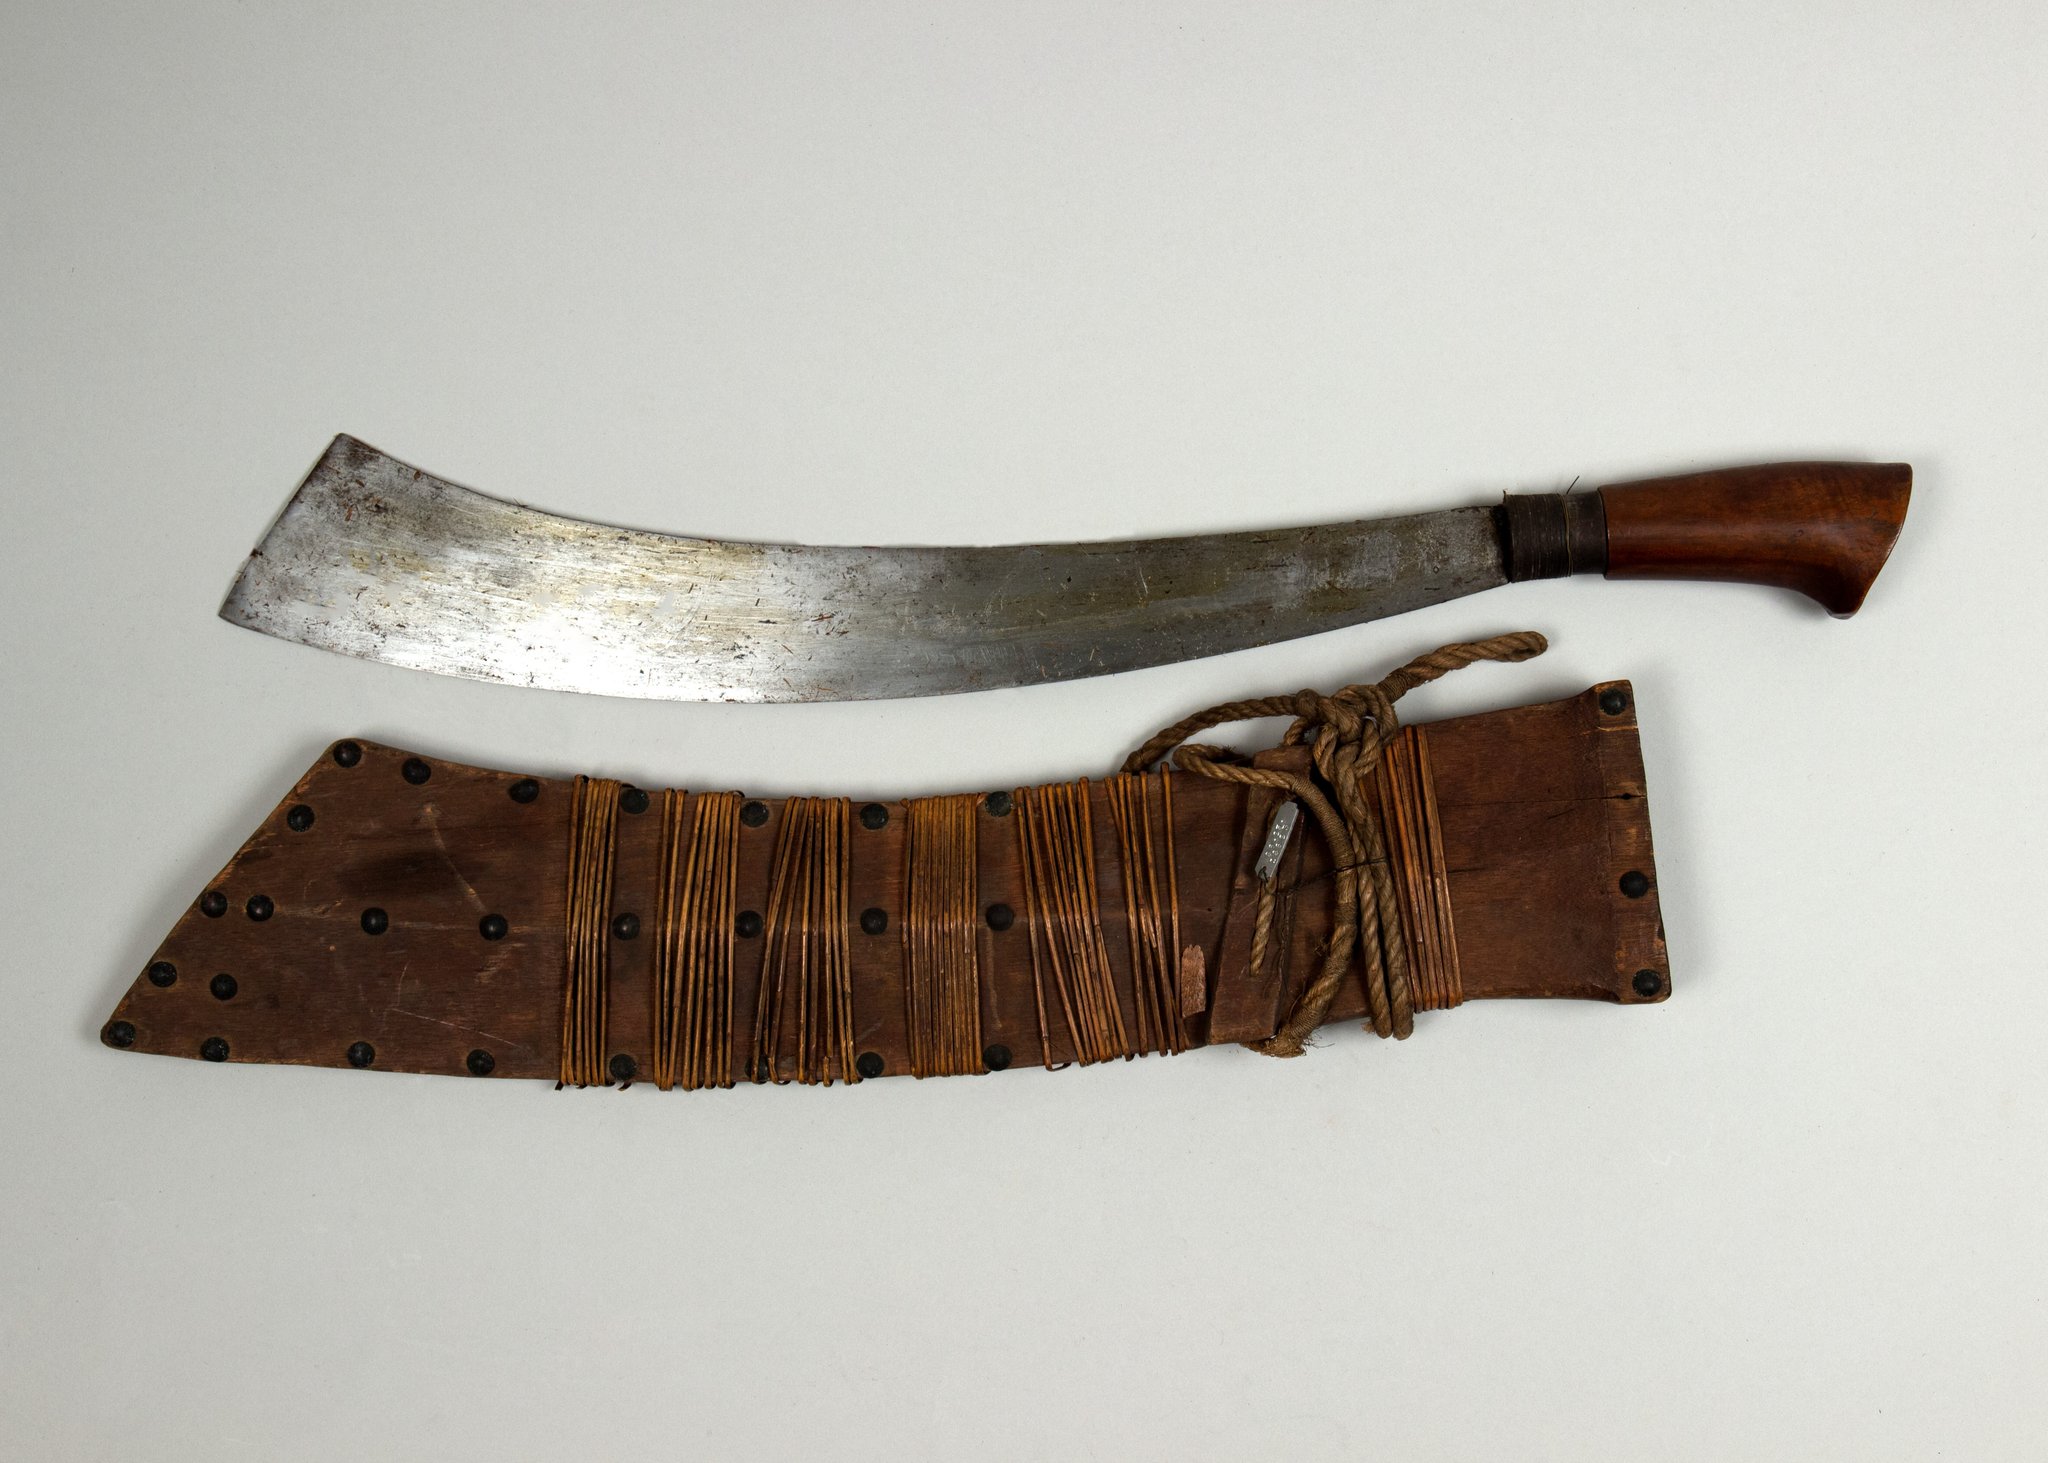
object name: knife with sheath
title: Jungle Knife with Sheath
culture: philippine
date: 1701-1900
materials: brass, steel, wood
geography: philippines